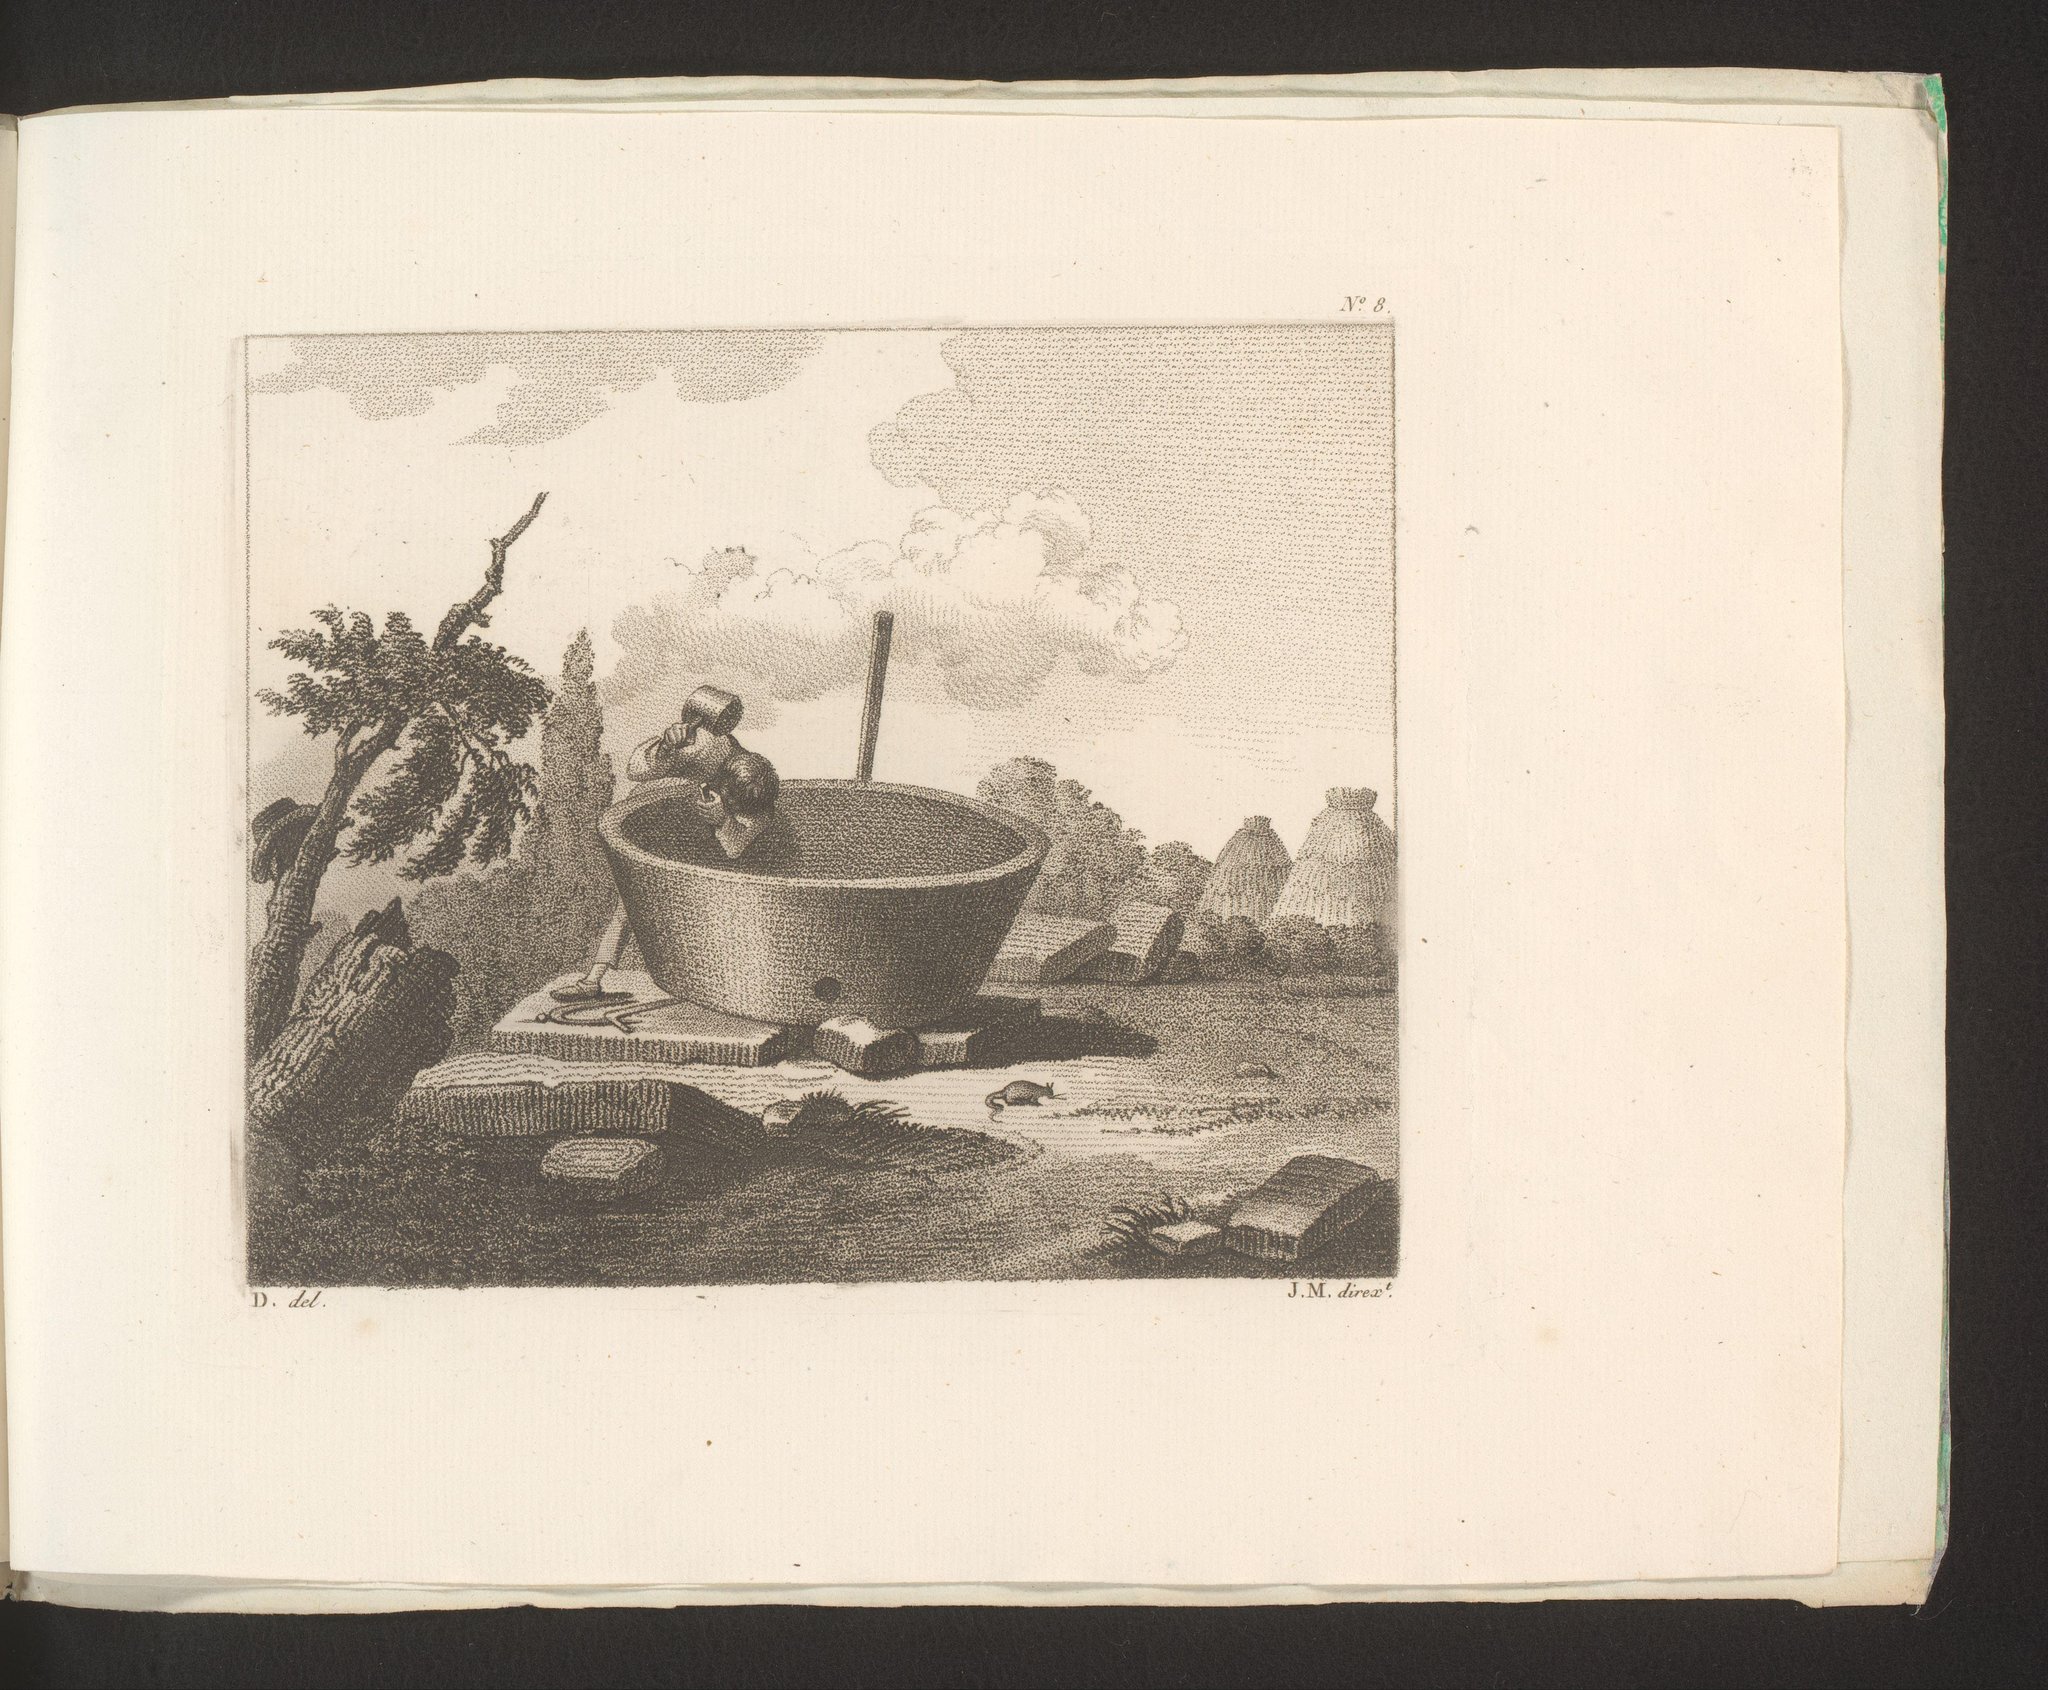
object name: print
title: 2me. cahier d'études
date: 1800-1825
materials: paper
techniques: printmaking, engraving, etching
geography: paris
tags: tools, aids, implements ~ crafts and industries: chisel, water-supply (~ public services), tools, aids, implements ~ crafts and industries: hammer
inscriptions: collector's mark: Lugt 2228, collector's mark: Lugt 2760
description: Deze prent maakt deel uit van een album.